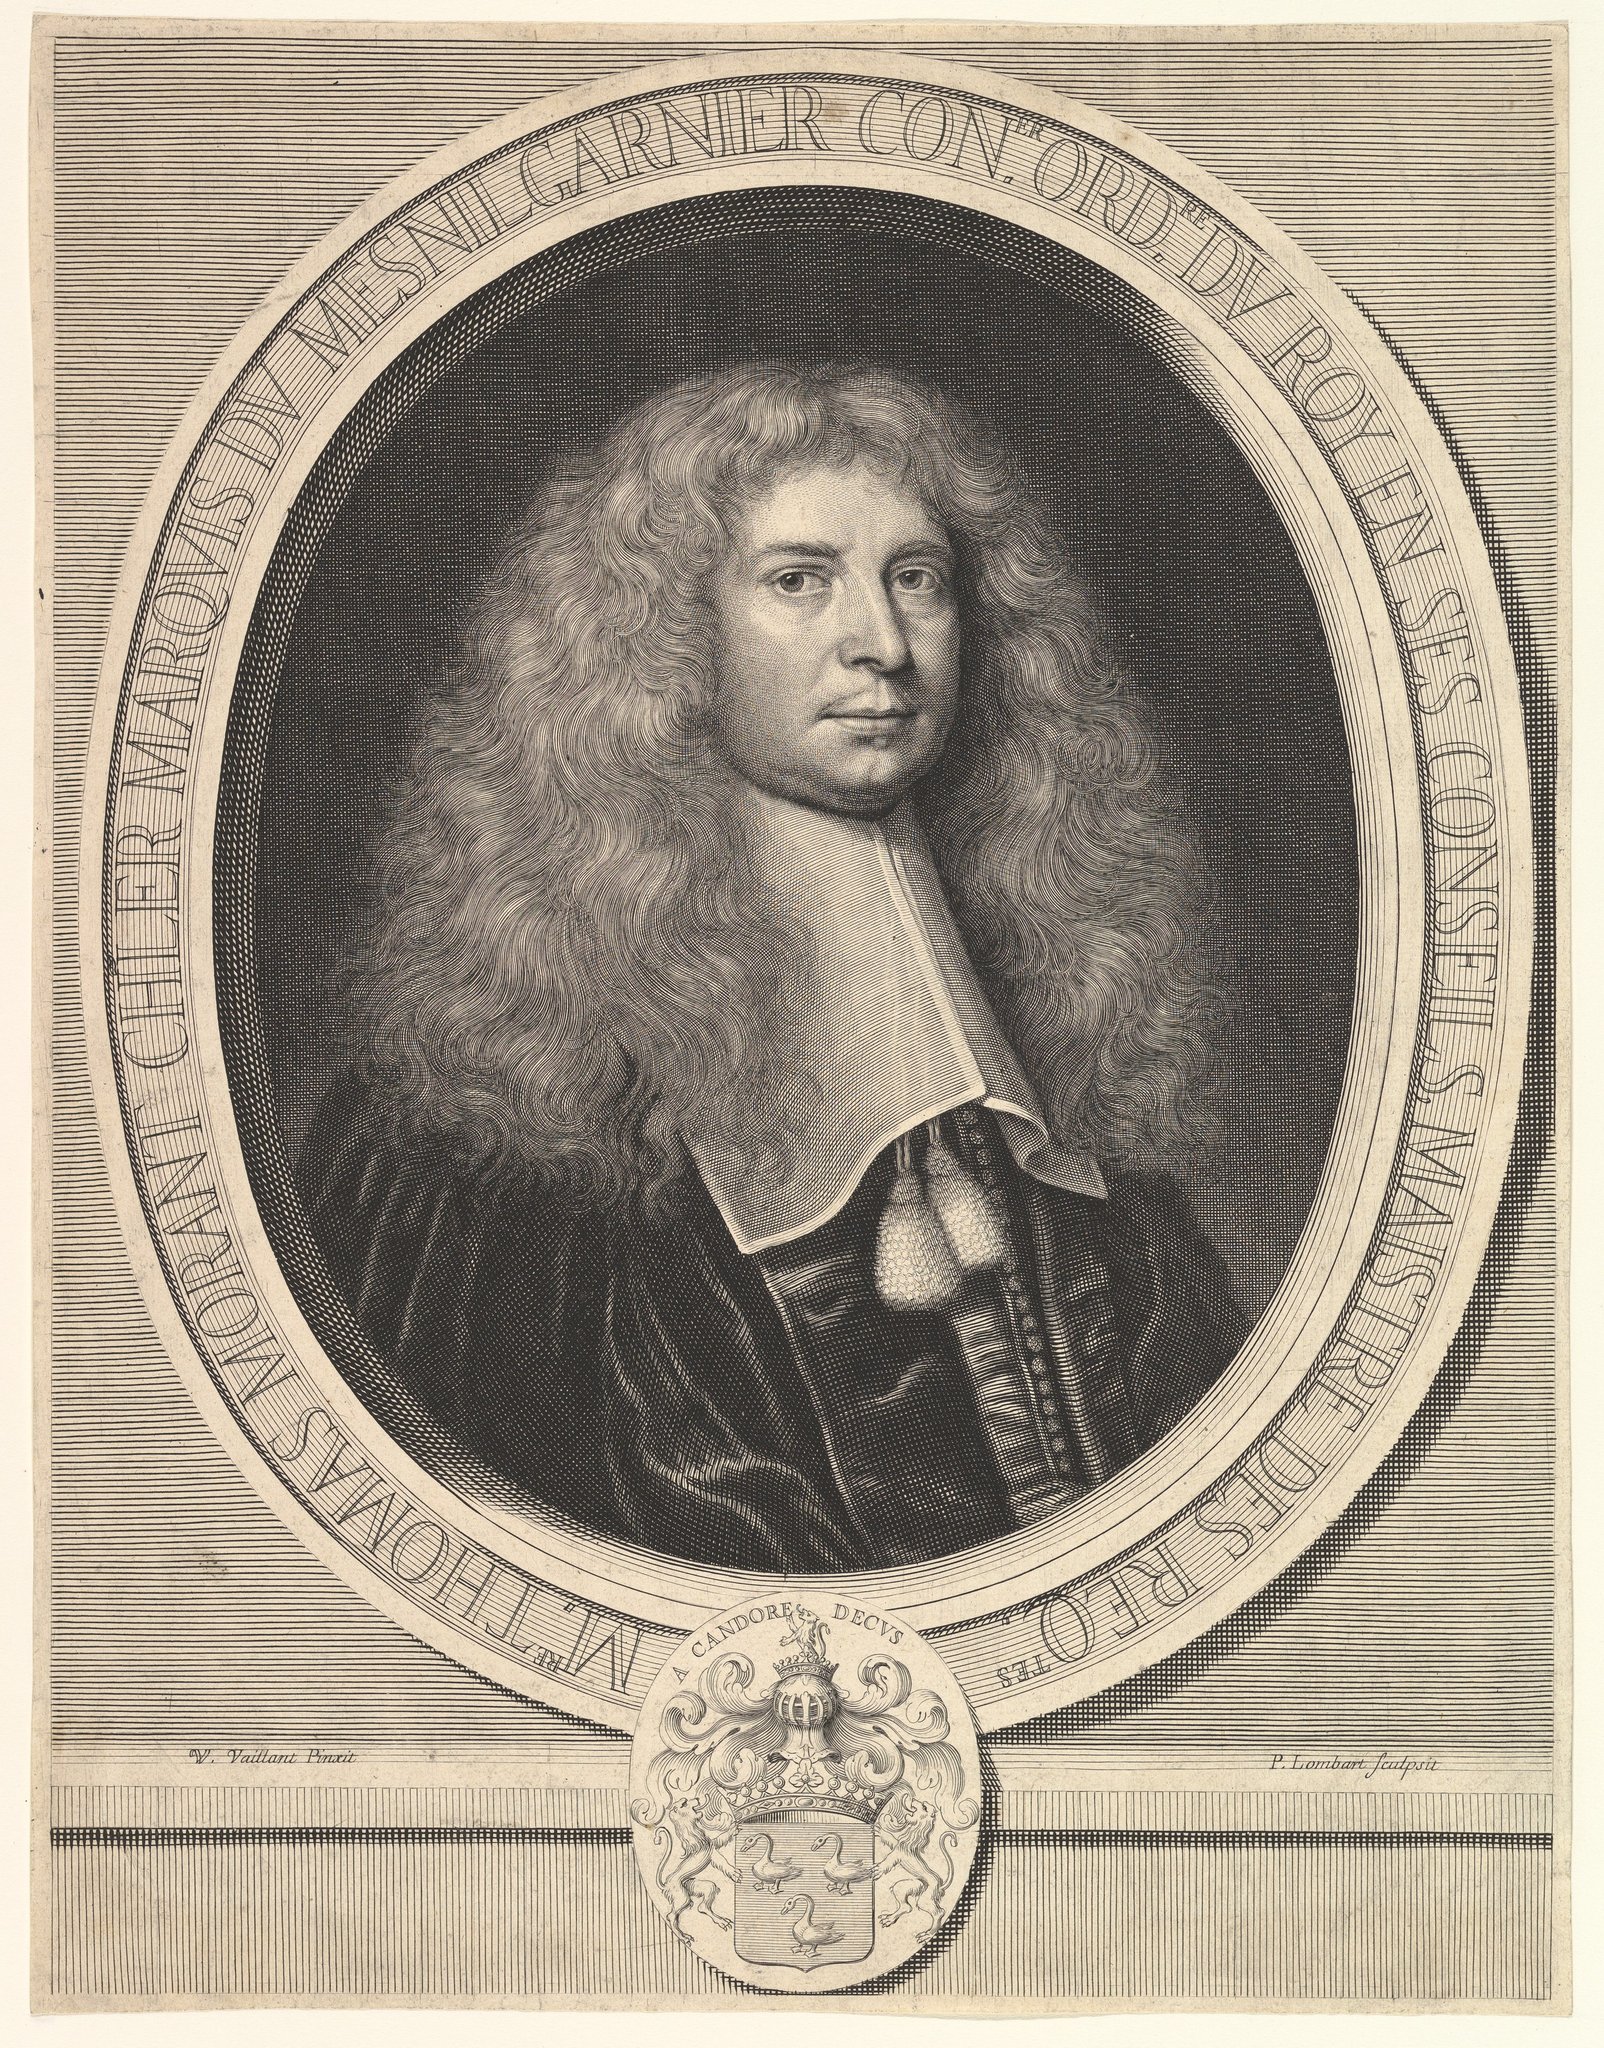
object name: print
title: Portrait of the Marquis du Mesnilgarnier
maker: pierre lombart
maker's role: artist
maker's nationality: french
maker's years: 1612-1682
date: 1601-1700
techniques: etching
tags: men,portraits,coat of arms